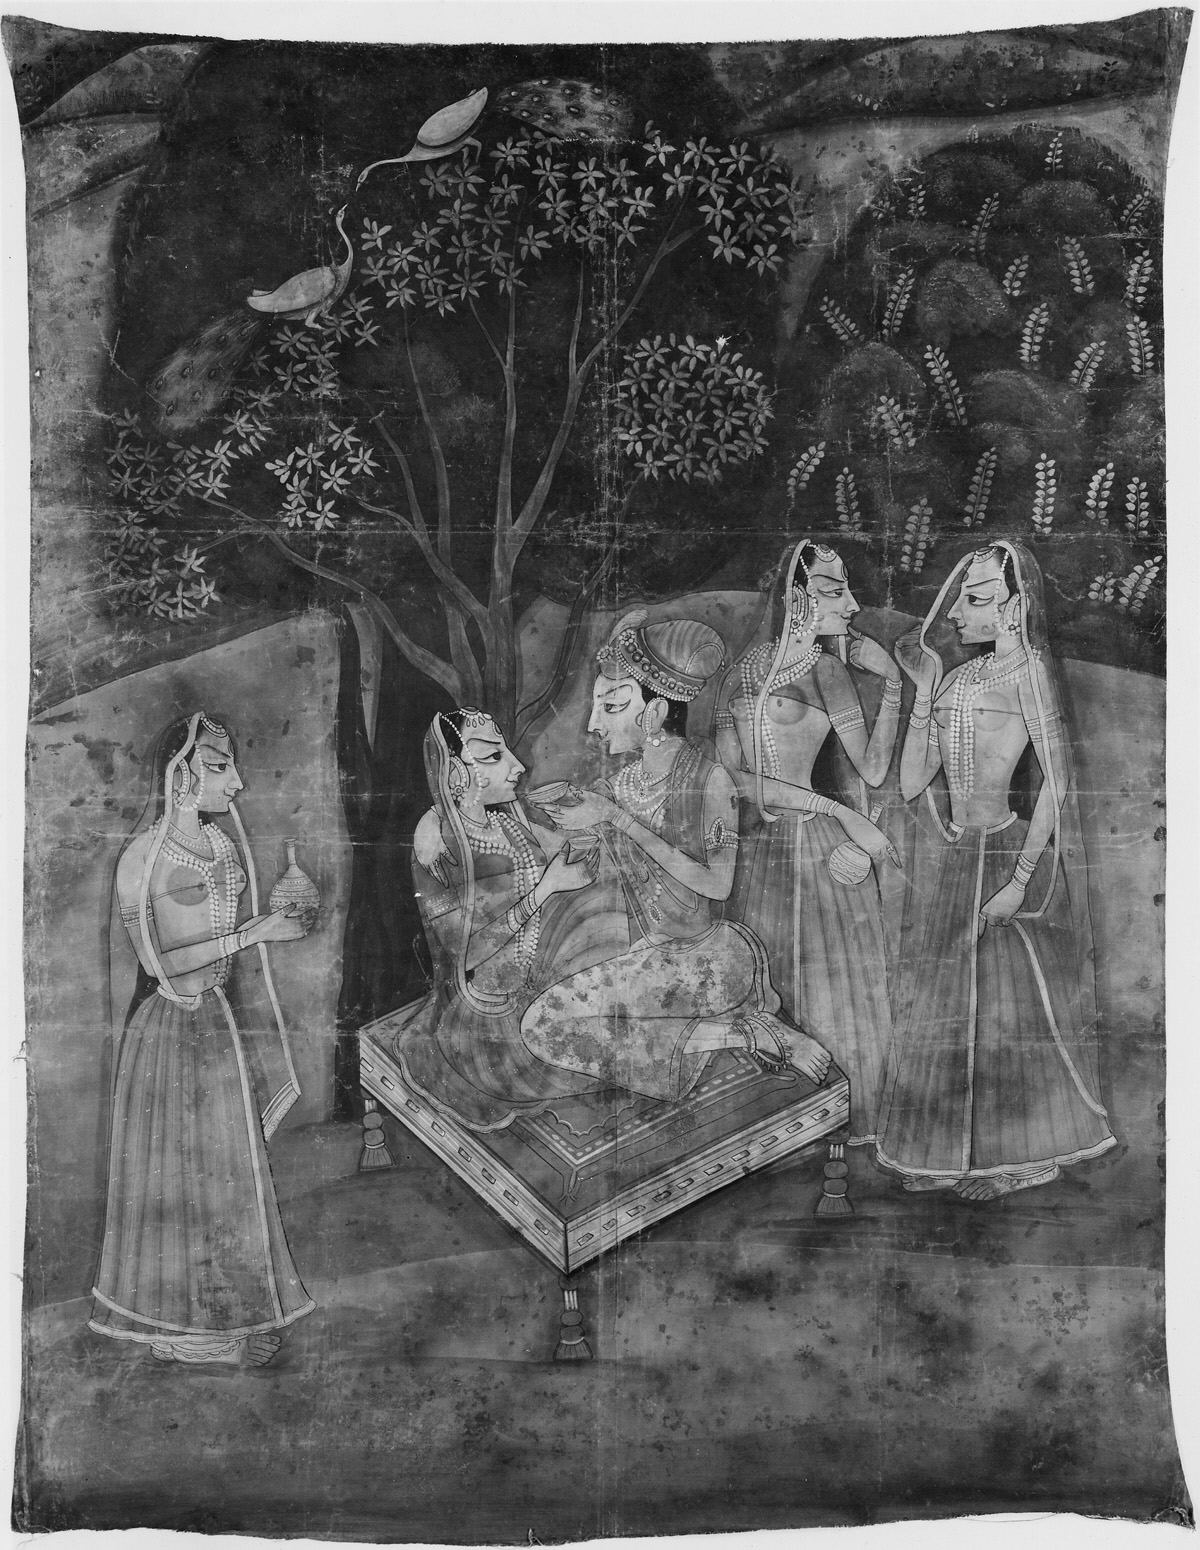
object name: wall hanging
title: The Triumph of Radha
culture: indian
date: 1901-2000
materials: cotton, gilt, ink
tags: women,female nudes,peacocks,krishna,radha,drinking